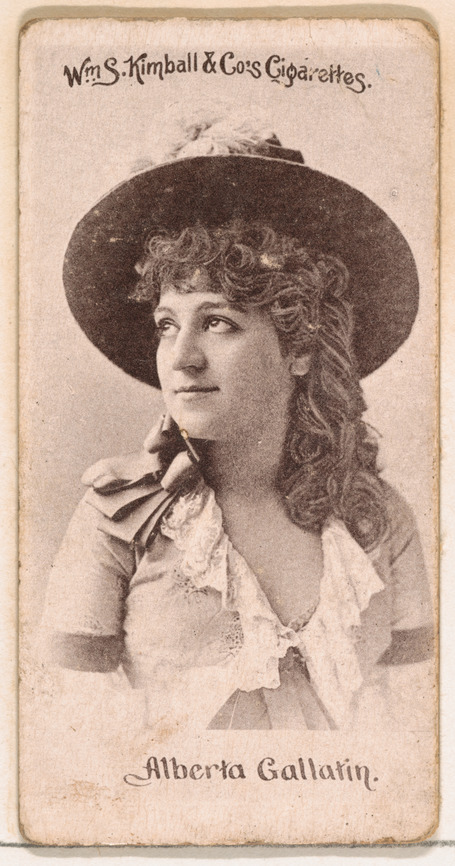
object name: print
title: Alberta Gallatin, from the Actresses series (N190) issued by Wm. S. Kimball & Co.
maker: william s. kimball & company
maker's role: publisher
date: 1889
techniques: lithography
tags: portraits,women,actresses